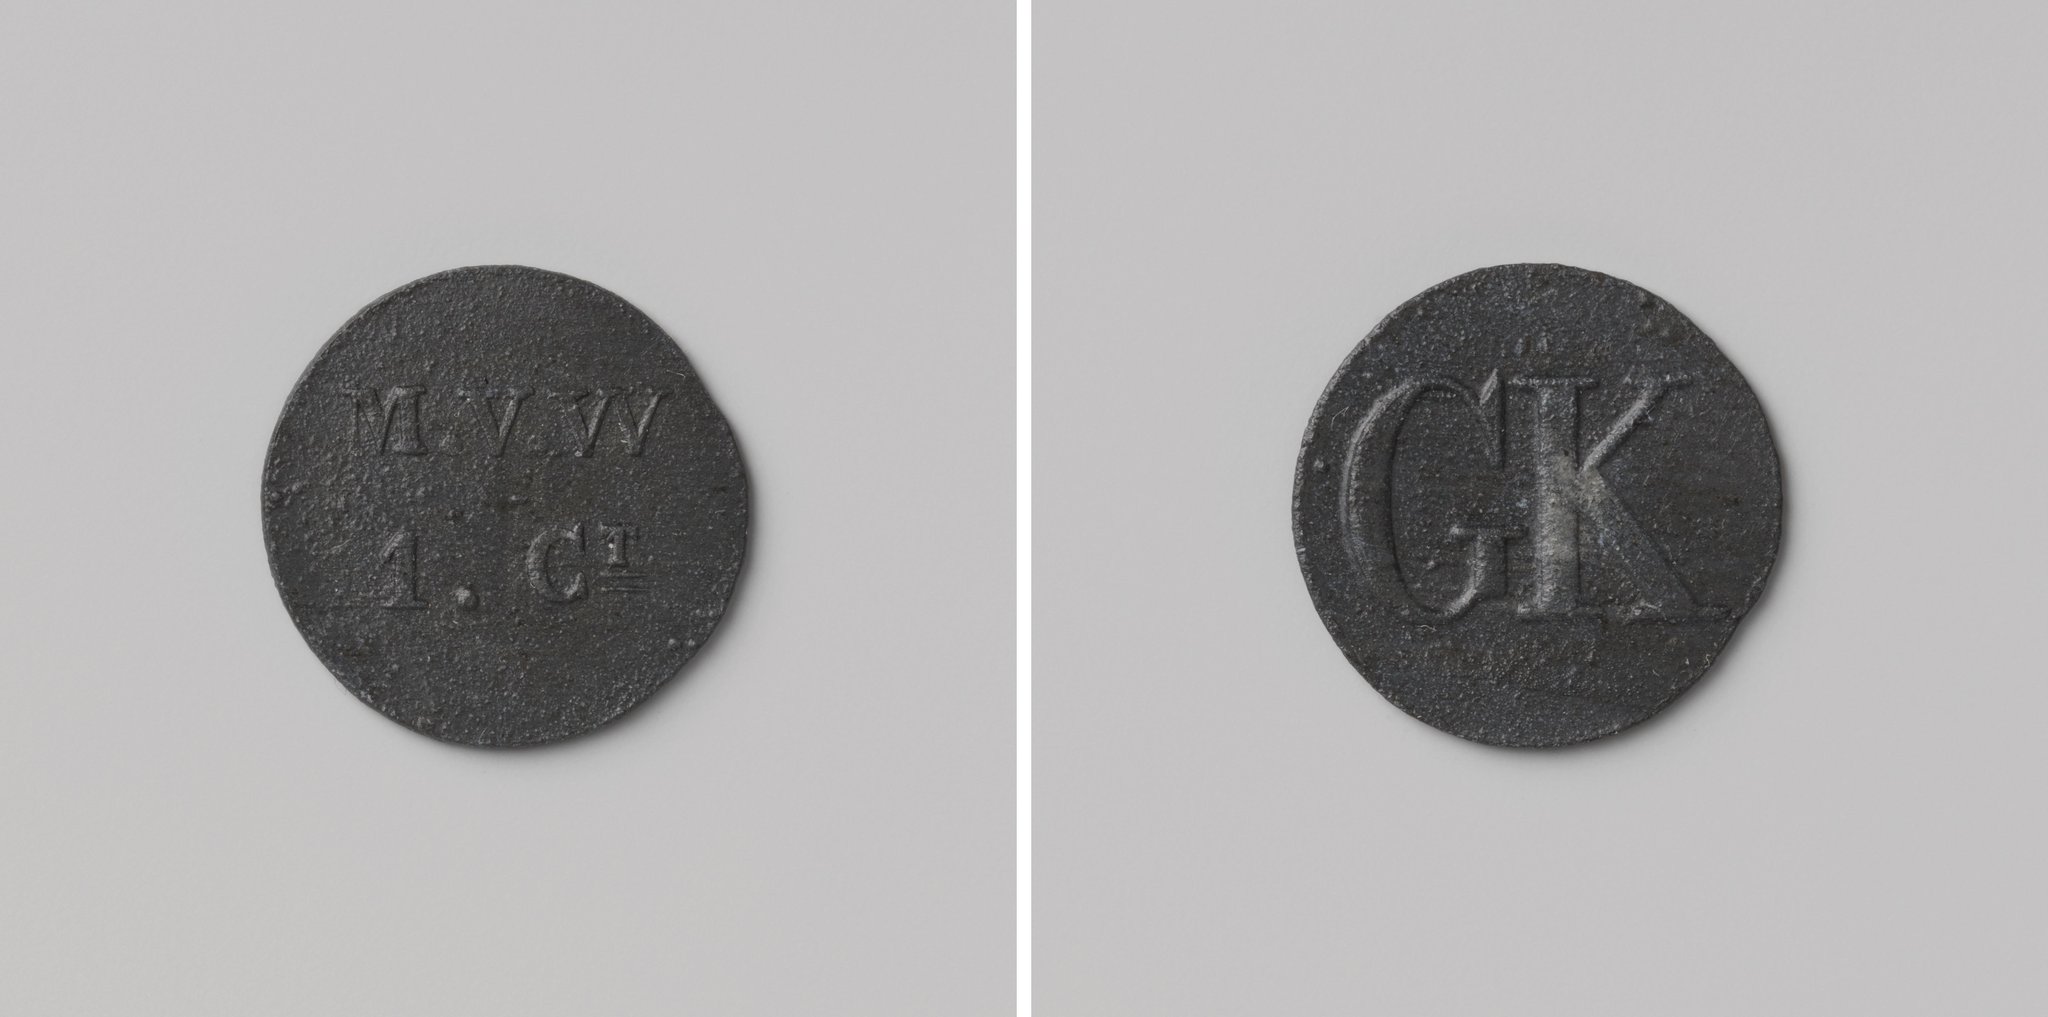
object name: huismunt prison money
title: Huismunt geslagen op last van de Maatschappij van Weldadigheid ter waarde van 1 cent, ten behoeve van de Gewone Koloniën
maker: Anonymous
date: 1818-1859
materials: zinc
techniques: striking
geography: netherlands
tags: maatschappij van weldadigheid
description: Zinken munt. Voorzijde: opschrift boven waardeaanduiding. Keerzijde: opschrift G en K